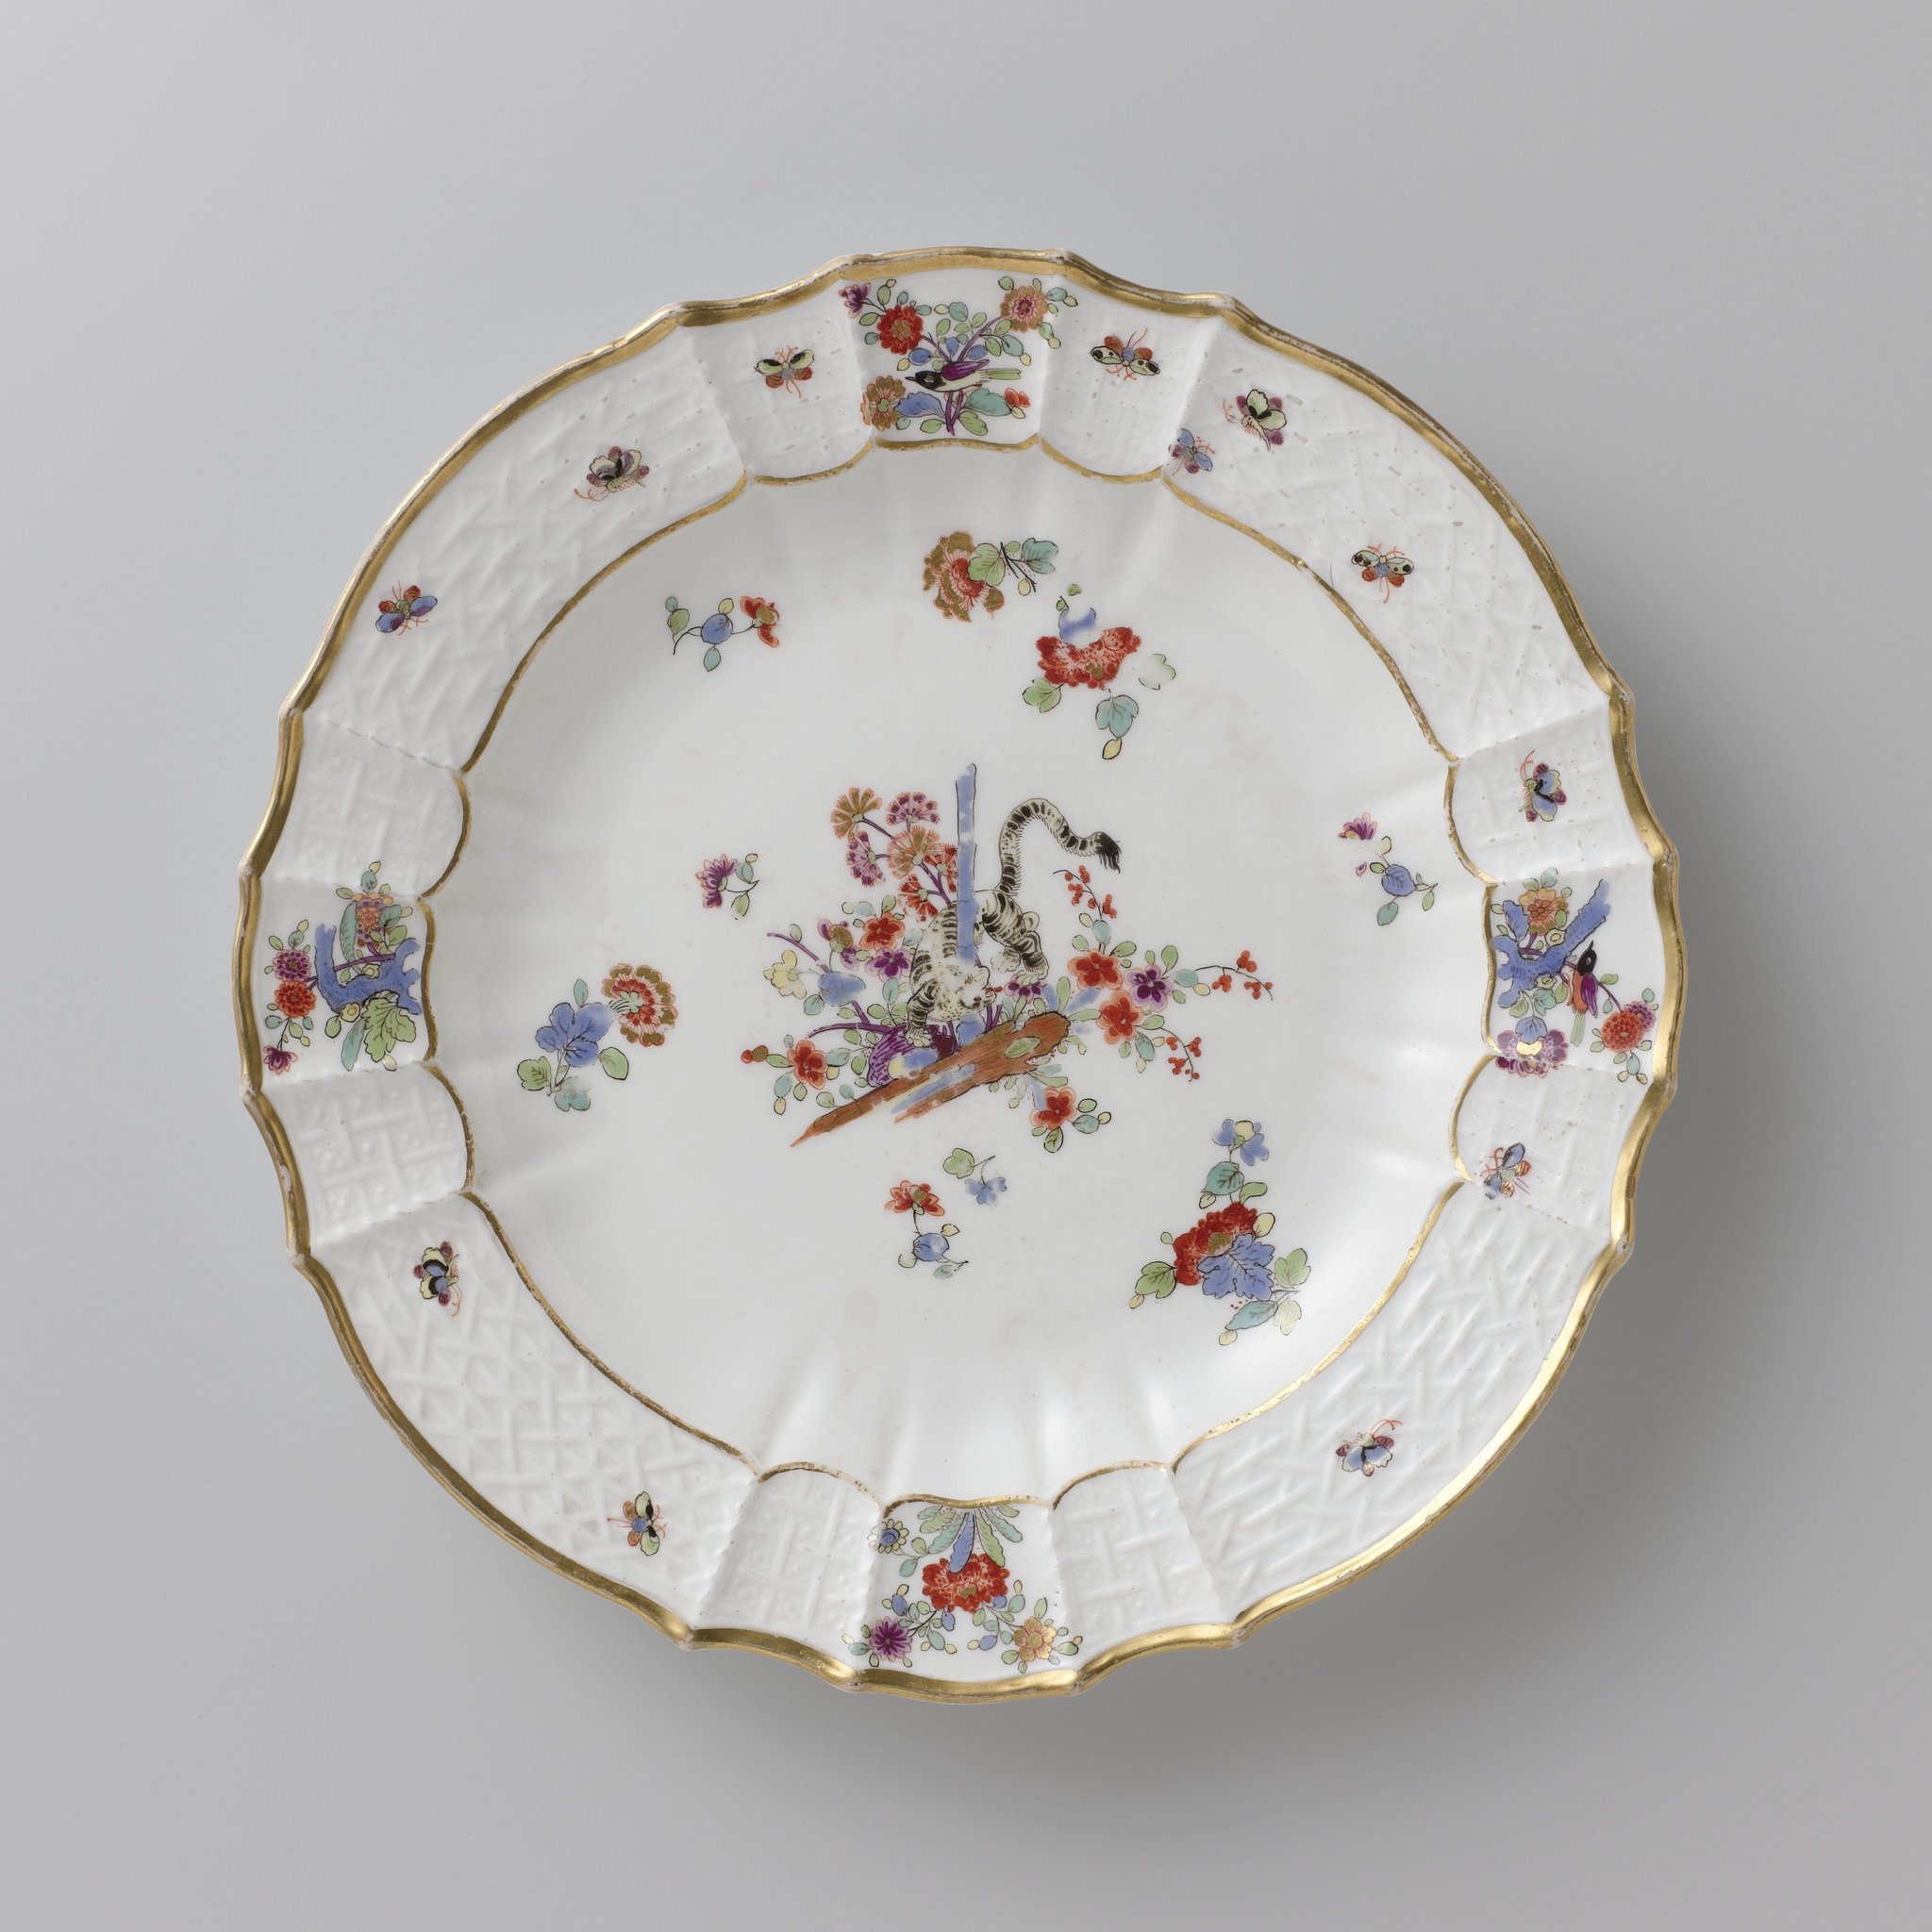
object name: plate dish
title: Rond bord, veelkleurig beschilderd met een Kakiemon-decor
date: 1740-1745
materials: porcelain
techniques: painted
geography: meissen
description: Rond bord van beschilderd porselein. Het bord is geribd en heeft een geschulpte rand. Het bord is beschilderd met een tijger die om een blauwe bamboestengel tussen bloemen is gedraaid, gestrooide Indianische Blumen, vlinders en takken waarop vogels. De rand is versierd met het 'Altbrandenstein'-patroon. Het bord is gemerkt.